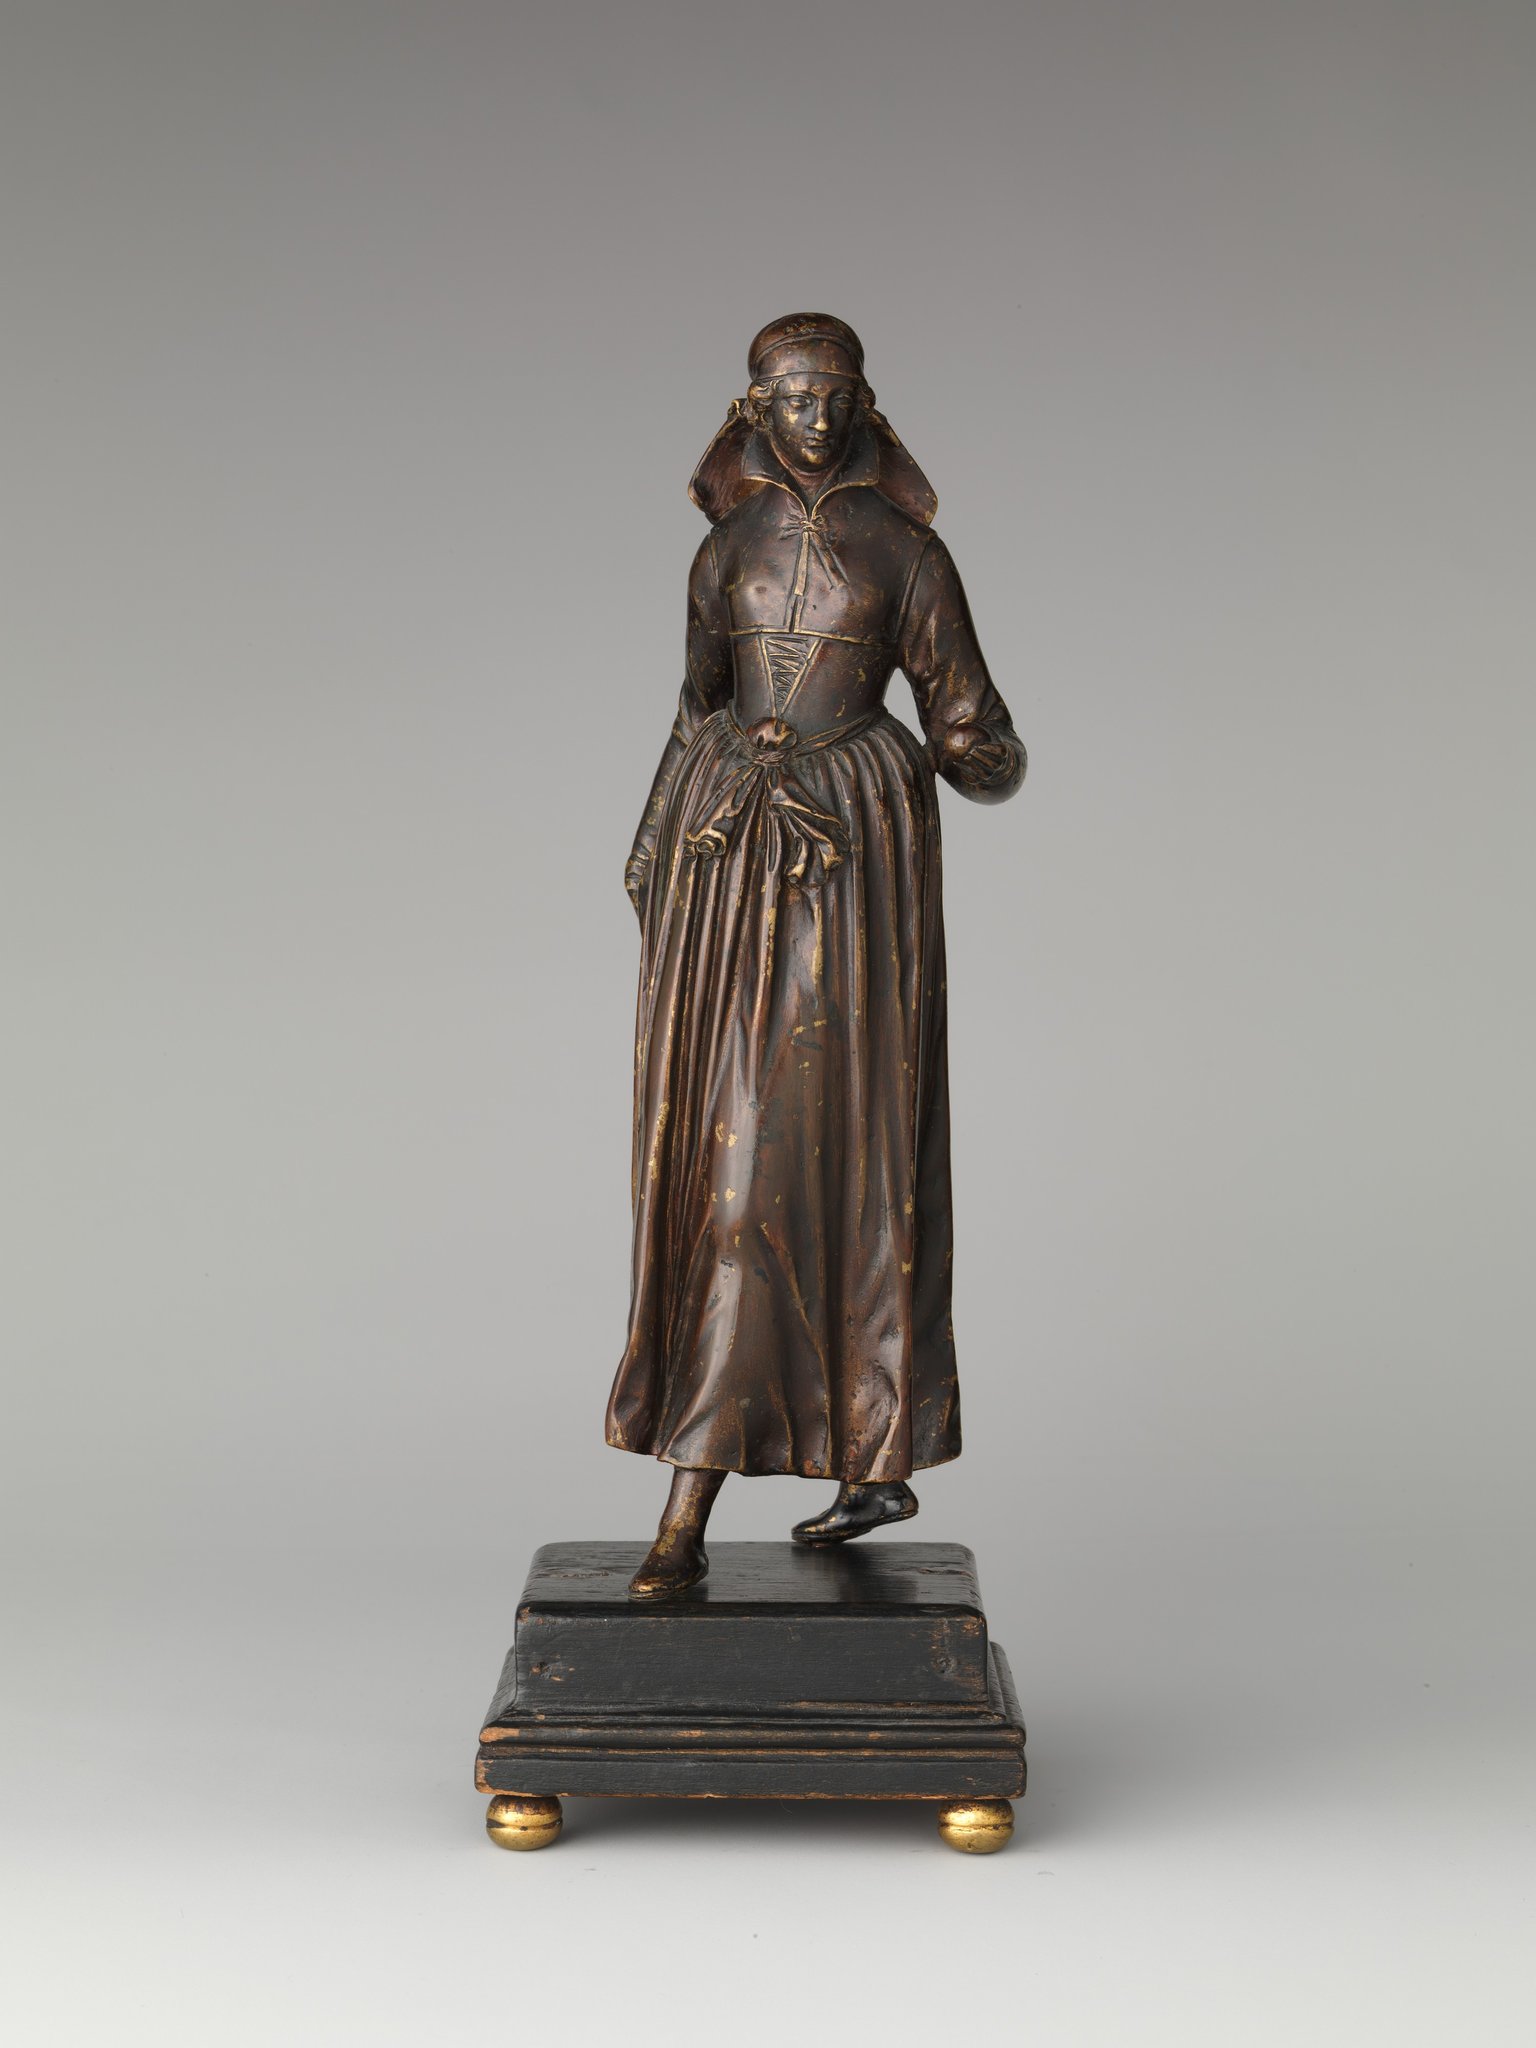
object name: statuette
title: Maiden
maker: barthélemy prieur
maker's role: artist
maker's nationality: french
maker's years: 1536-1611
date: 1585-1594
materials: bronze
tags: women